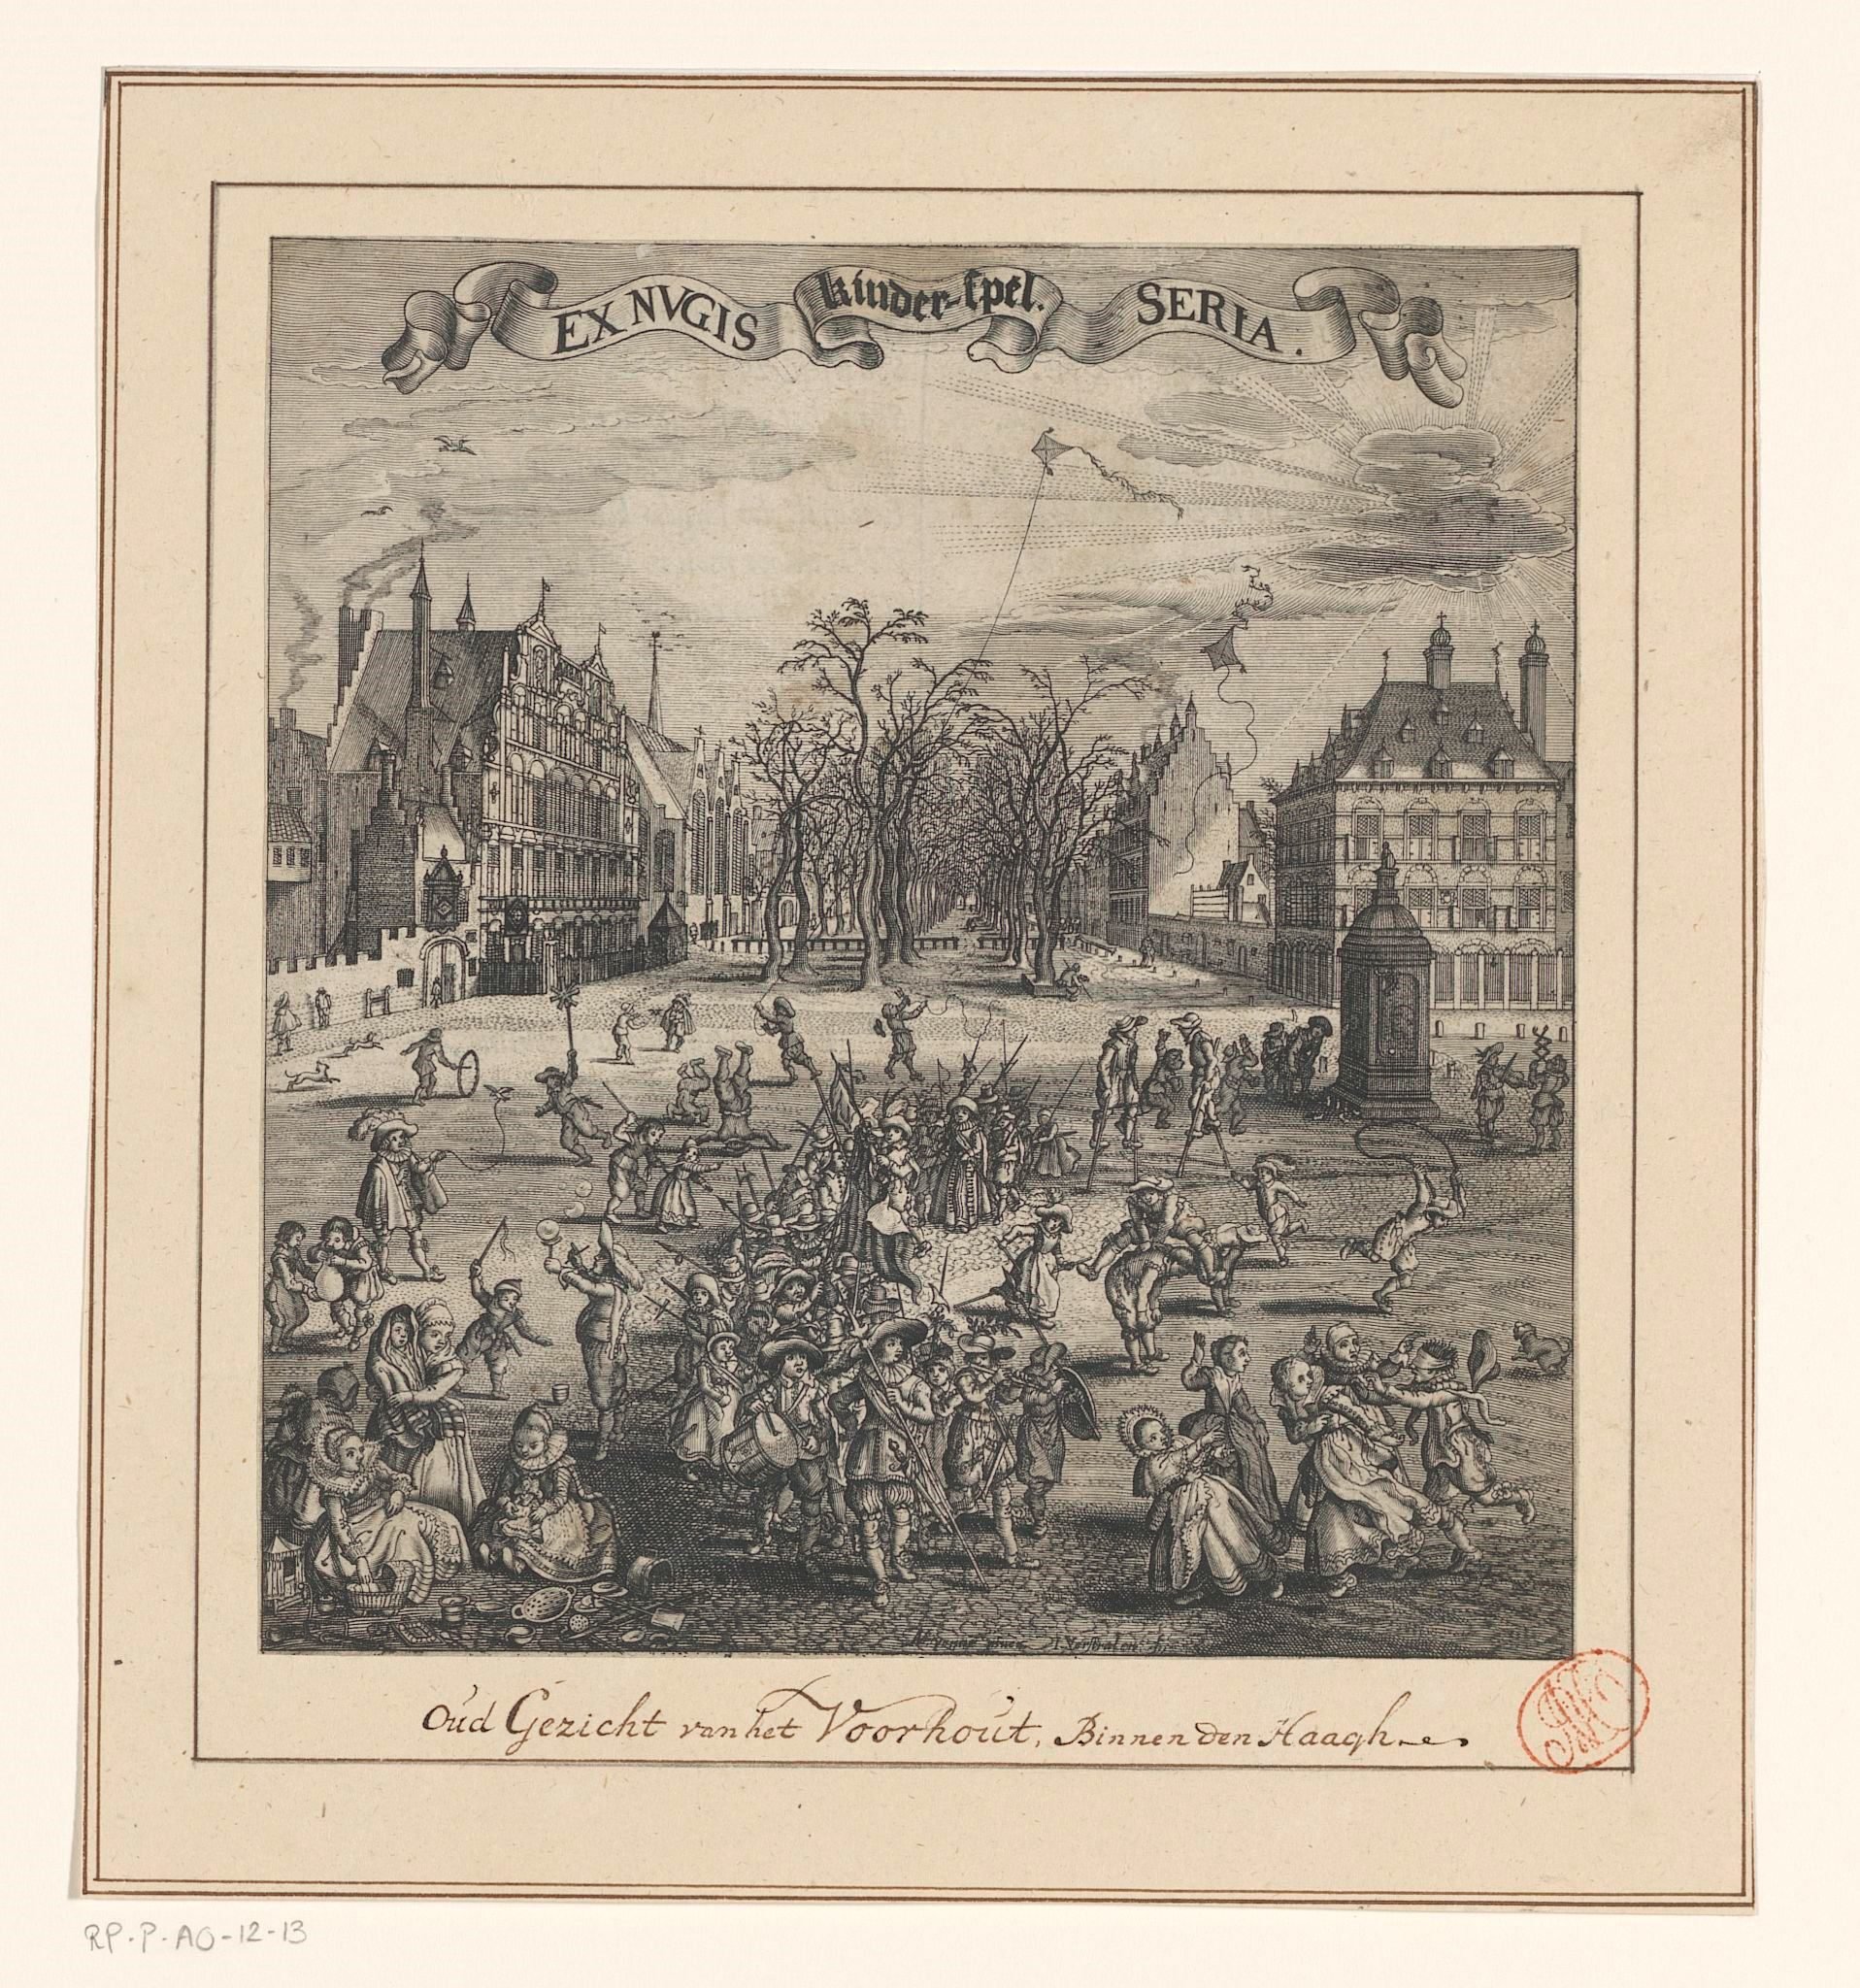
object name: print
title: Kinder-spel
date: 1625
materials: ink, paper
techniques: engraving, etching, letterpress printing, pen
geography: middelburg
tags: children's games and plays, (playing with) toys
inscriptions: collector's mark: Lugt 2228, inscription: ‘Oud gezicht van het Voorhout, binnen Den Haagh’, collector's mark: Lugt 195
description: Prent gebruikt in: Cats, Jacob. Houwelyck. Dat is de gansche gelegentheyt des echten staets. Middelburg: weduwe Jan Pietersz. van de Venne, 1625.